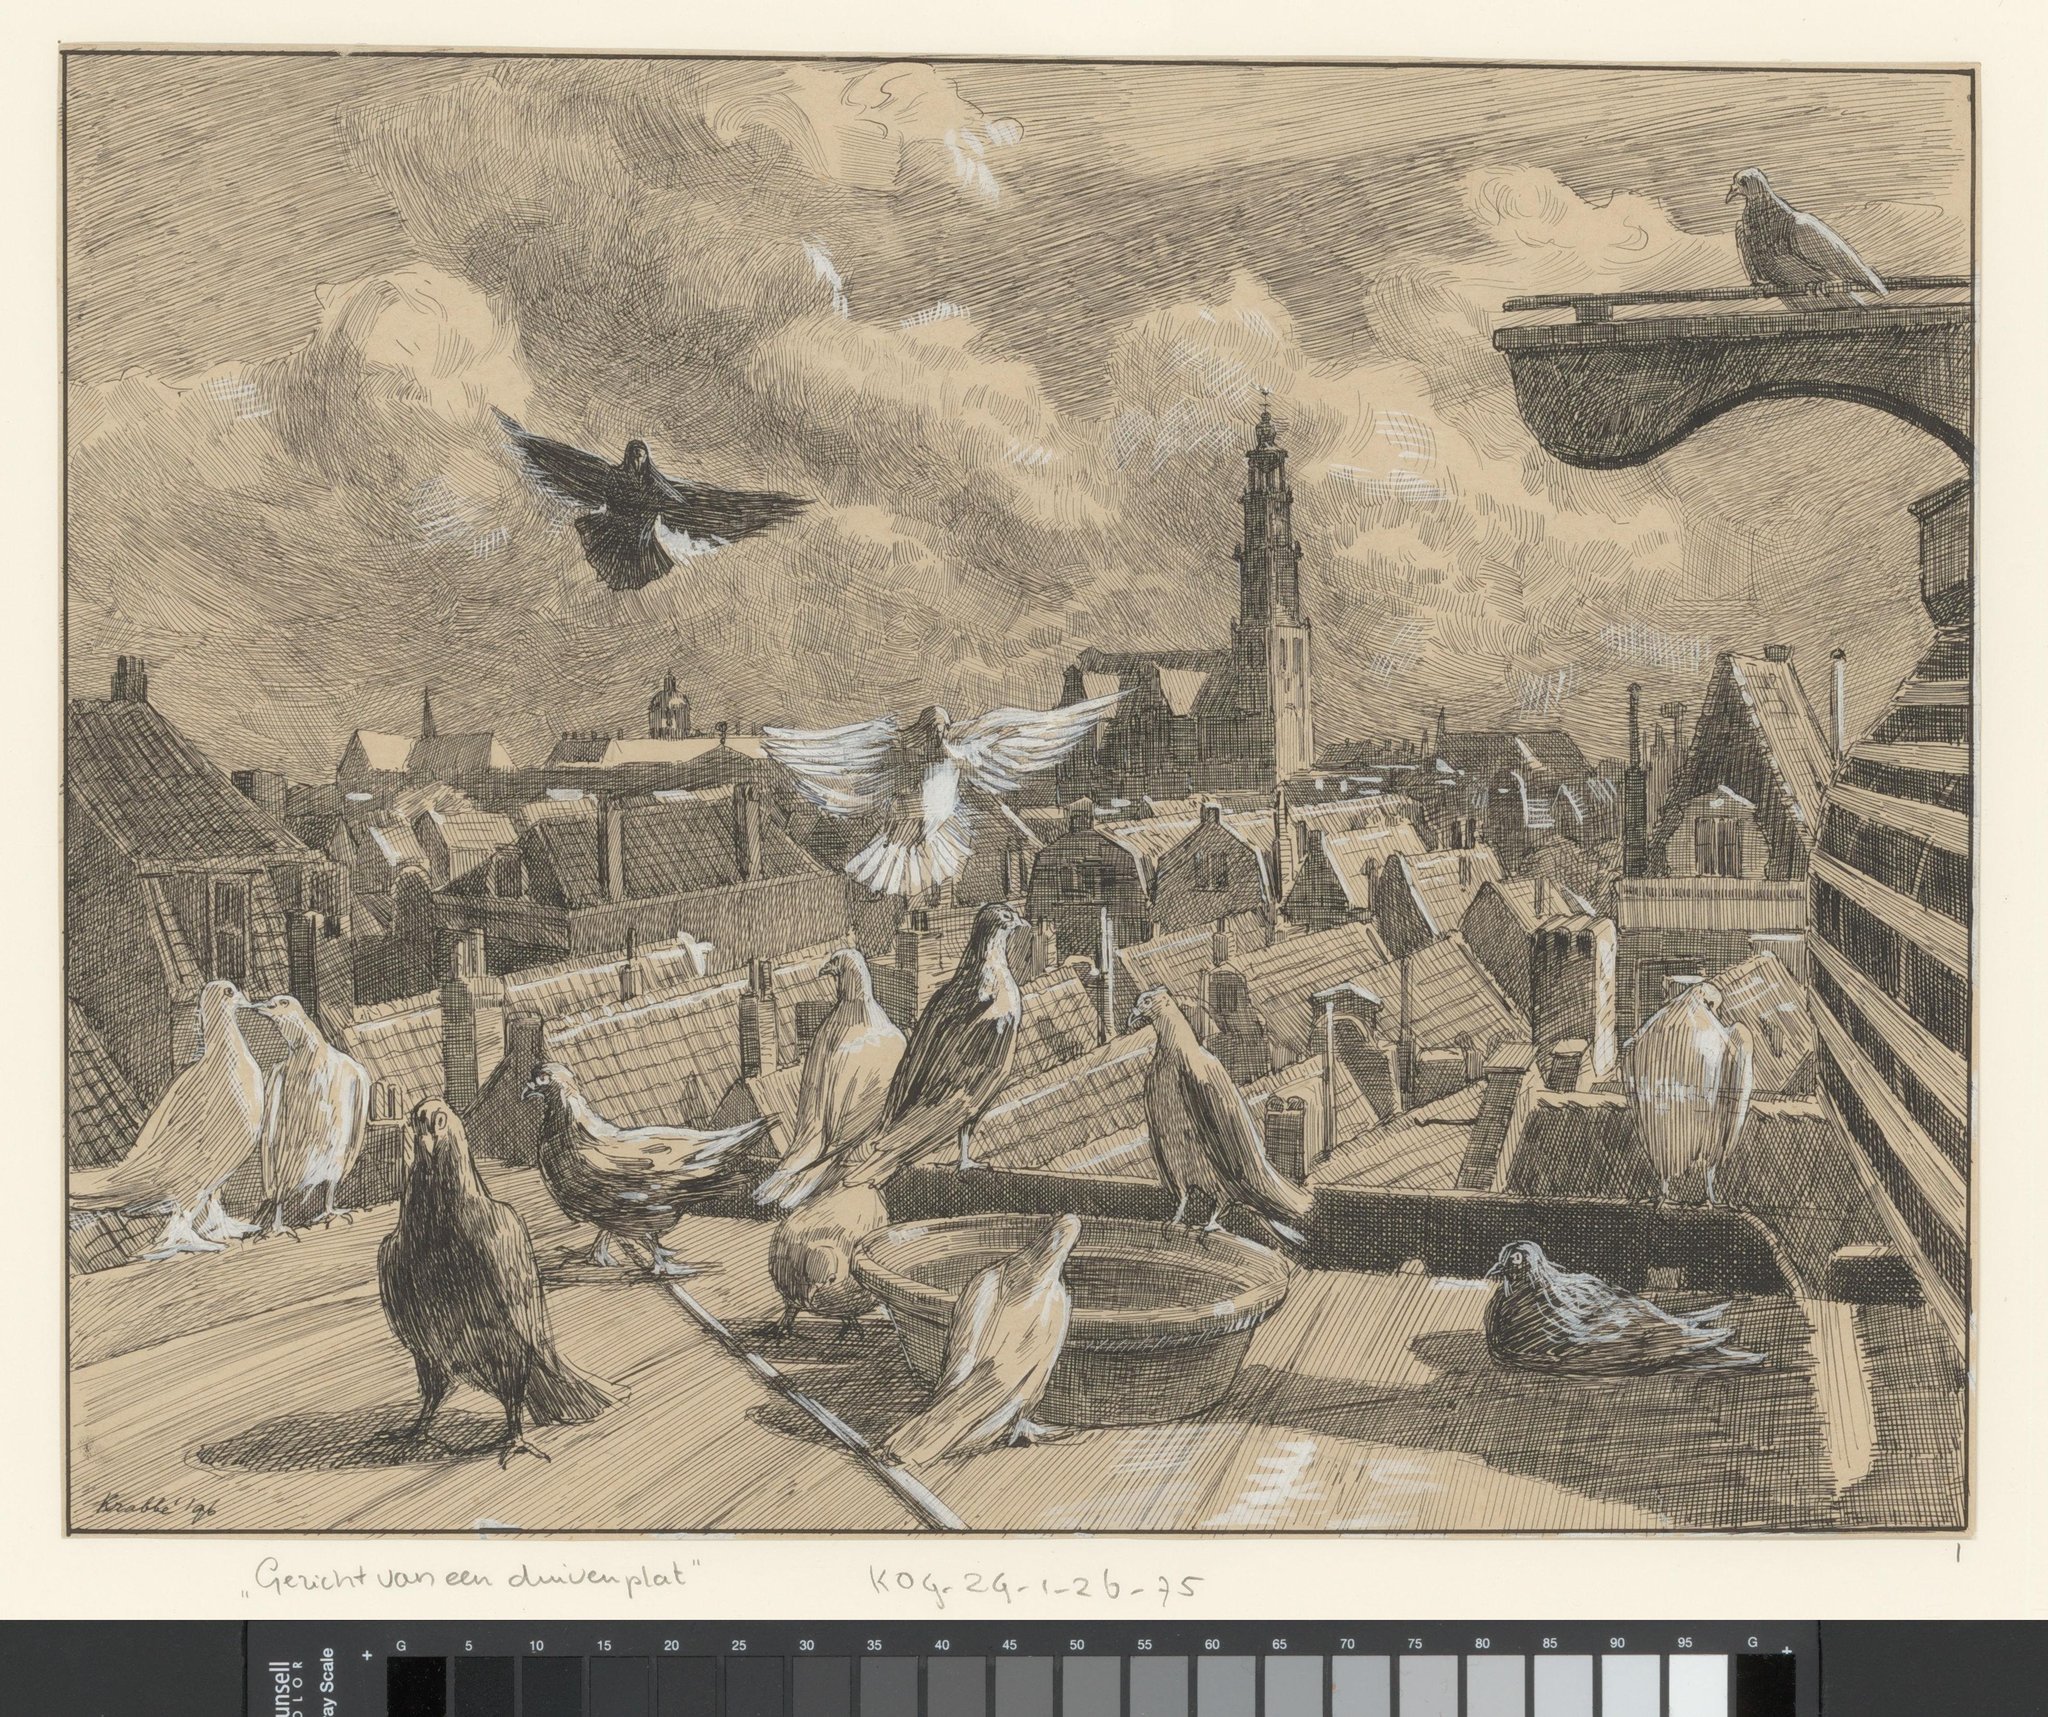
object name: drawing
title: Gezicht van een duivenplat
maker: heinrich m. krabbé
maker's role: draughtsman, print maker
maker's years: 1868-1931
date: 1896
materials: paint, ink, paper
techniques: brush, pen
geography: netherlands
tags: roof (of house or building), pigeons (racing), prospect of city, town panorama, silhouette of city, doves, pigeons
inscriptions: collector's mark: Lugt 1641, collector's mark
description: Duiven op het platte dak van een woning, in de Amsterdamse Jordaan. Gezicht over de daken van de huizen naar de Westertoren. Onderwerpsrubrieken binnen de Atlas Zeden en Gewoonten: Spel en Vermaak; Duiven in de Jordaan.